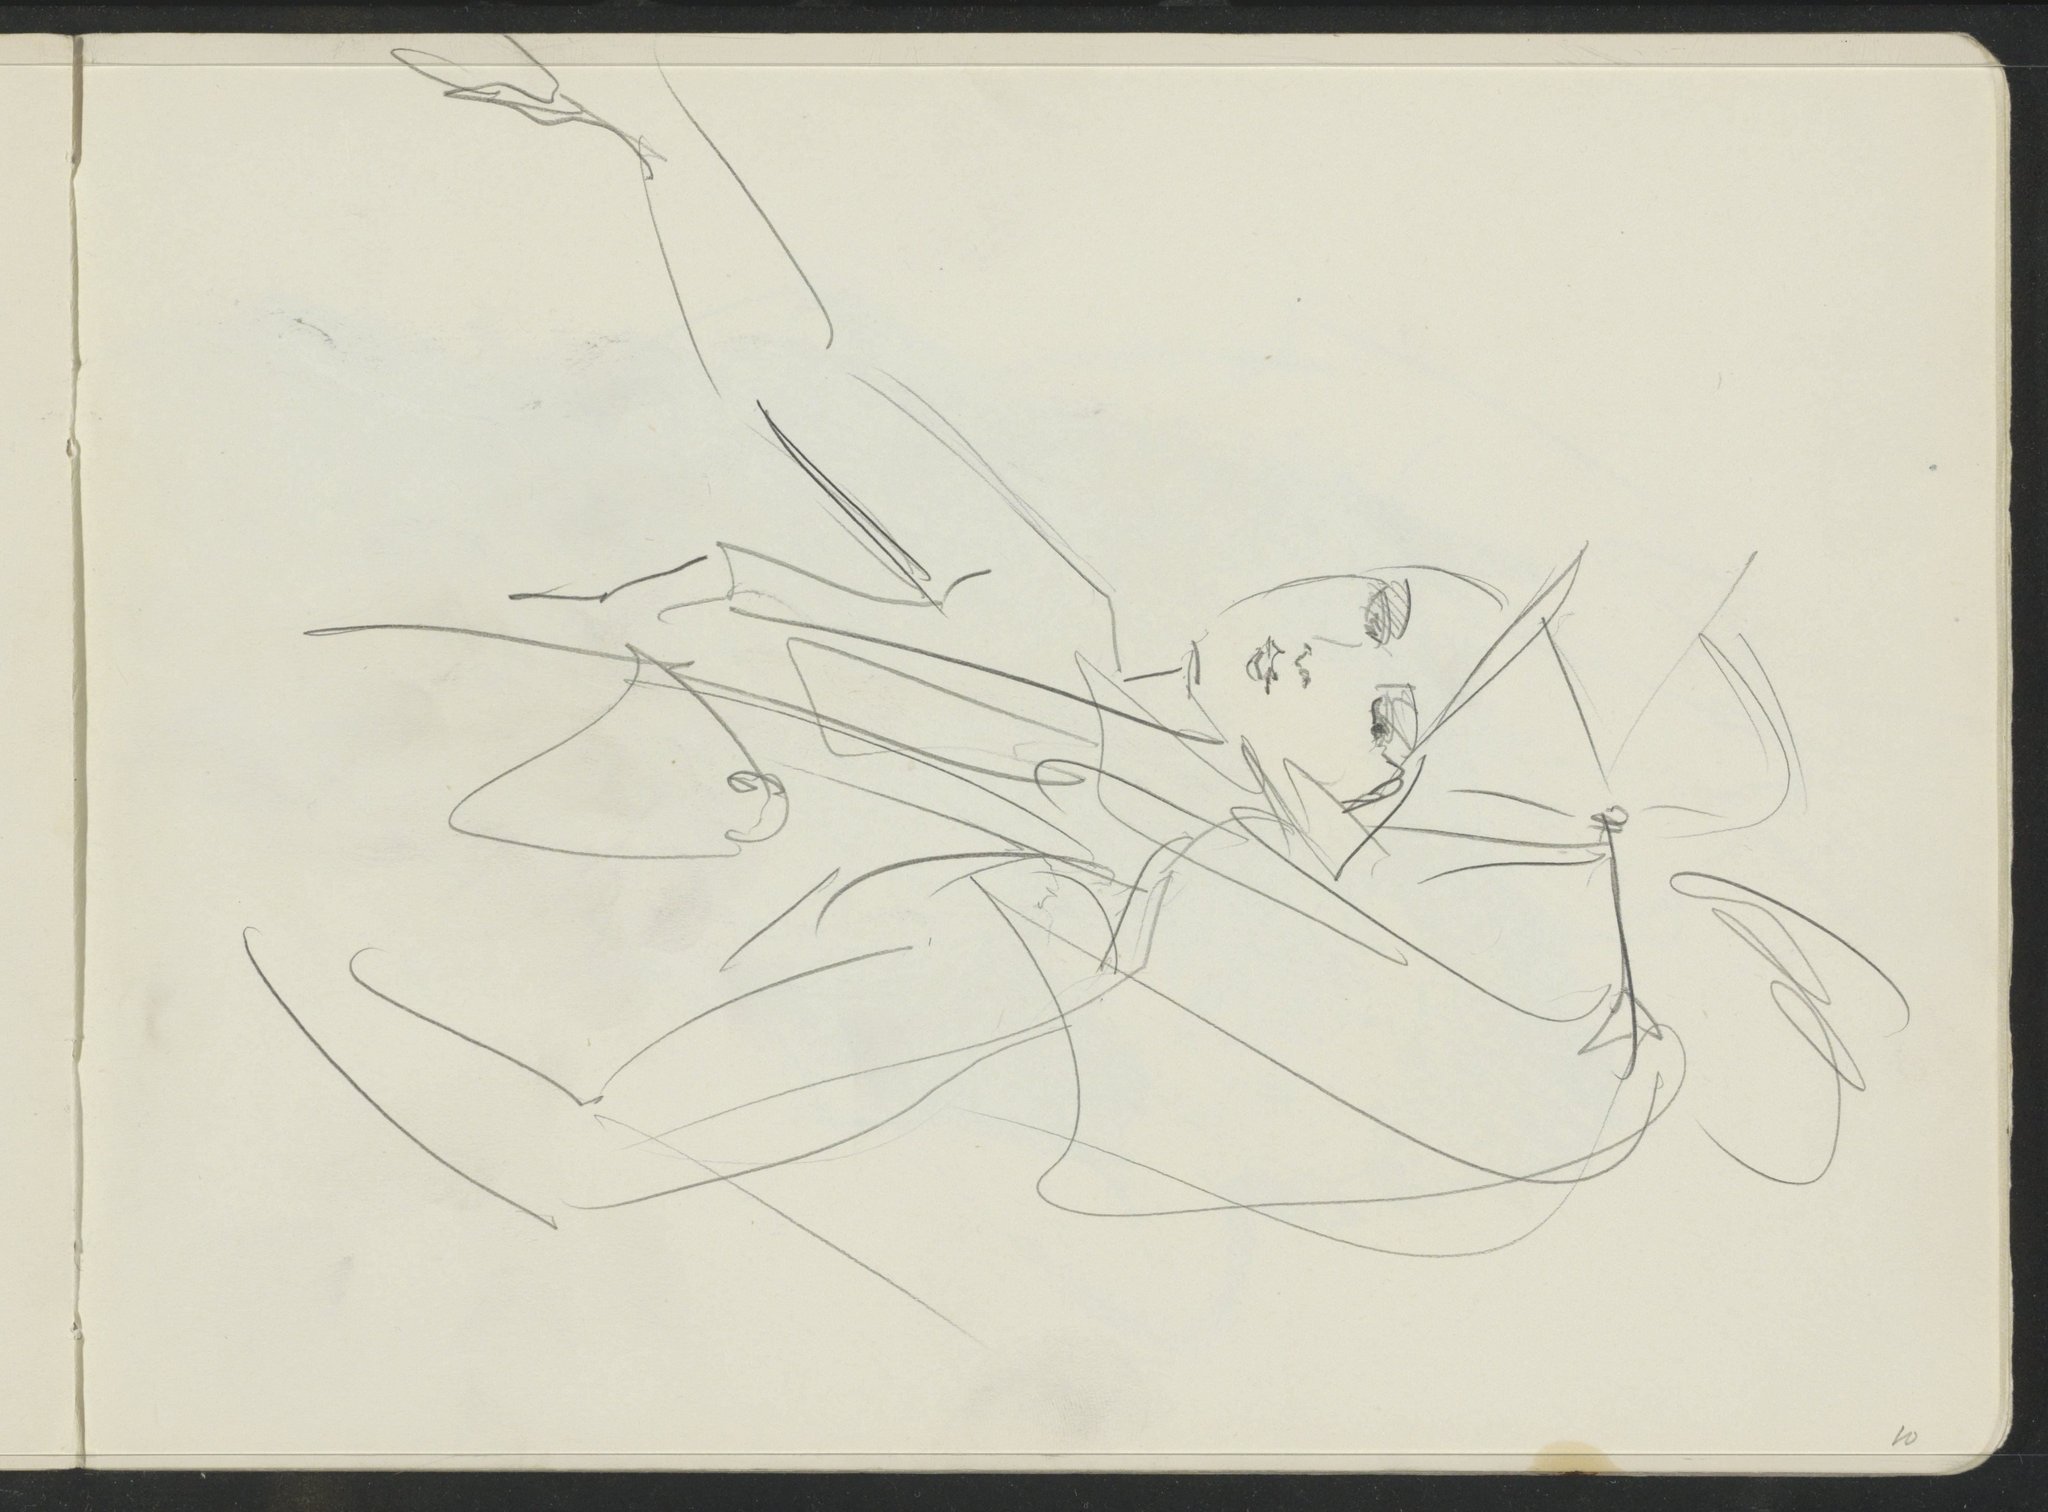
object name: sketchbook leaf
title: Vrouw met hoofdtooi, mogelijk een reveudanseres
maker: isaac israels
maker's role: draughtsman, painter, print maker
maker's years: 1865-1934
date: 1915-1934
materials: paper, pencil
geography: the hague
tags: adult woman, female dancer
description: Blad 10 recto uit schetsboek XV met 22 bladen.